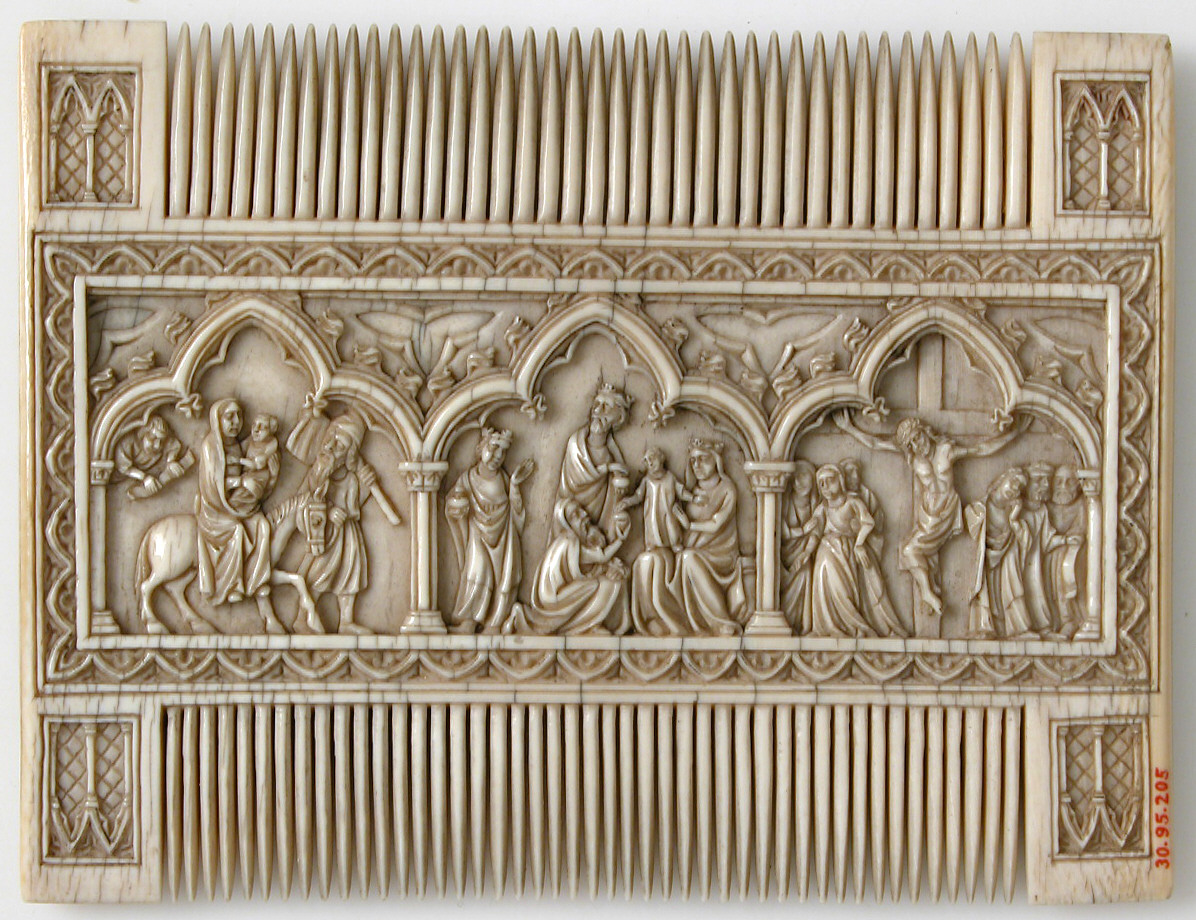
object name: comb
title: Comb with Scenes from the Life of Christ and the Virgin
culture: european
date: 1801-1900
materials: ivory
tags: christ,virgin mary,adoration of the magi,crucifixion